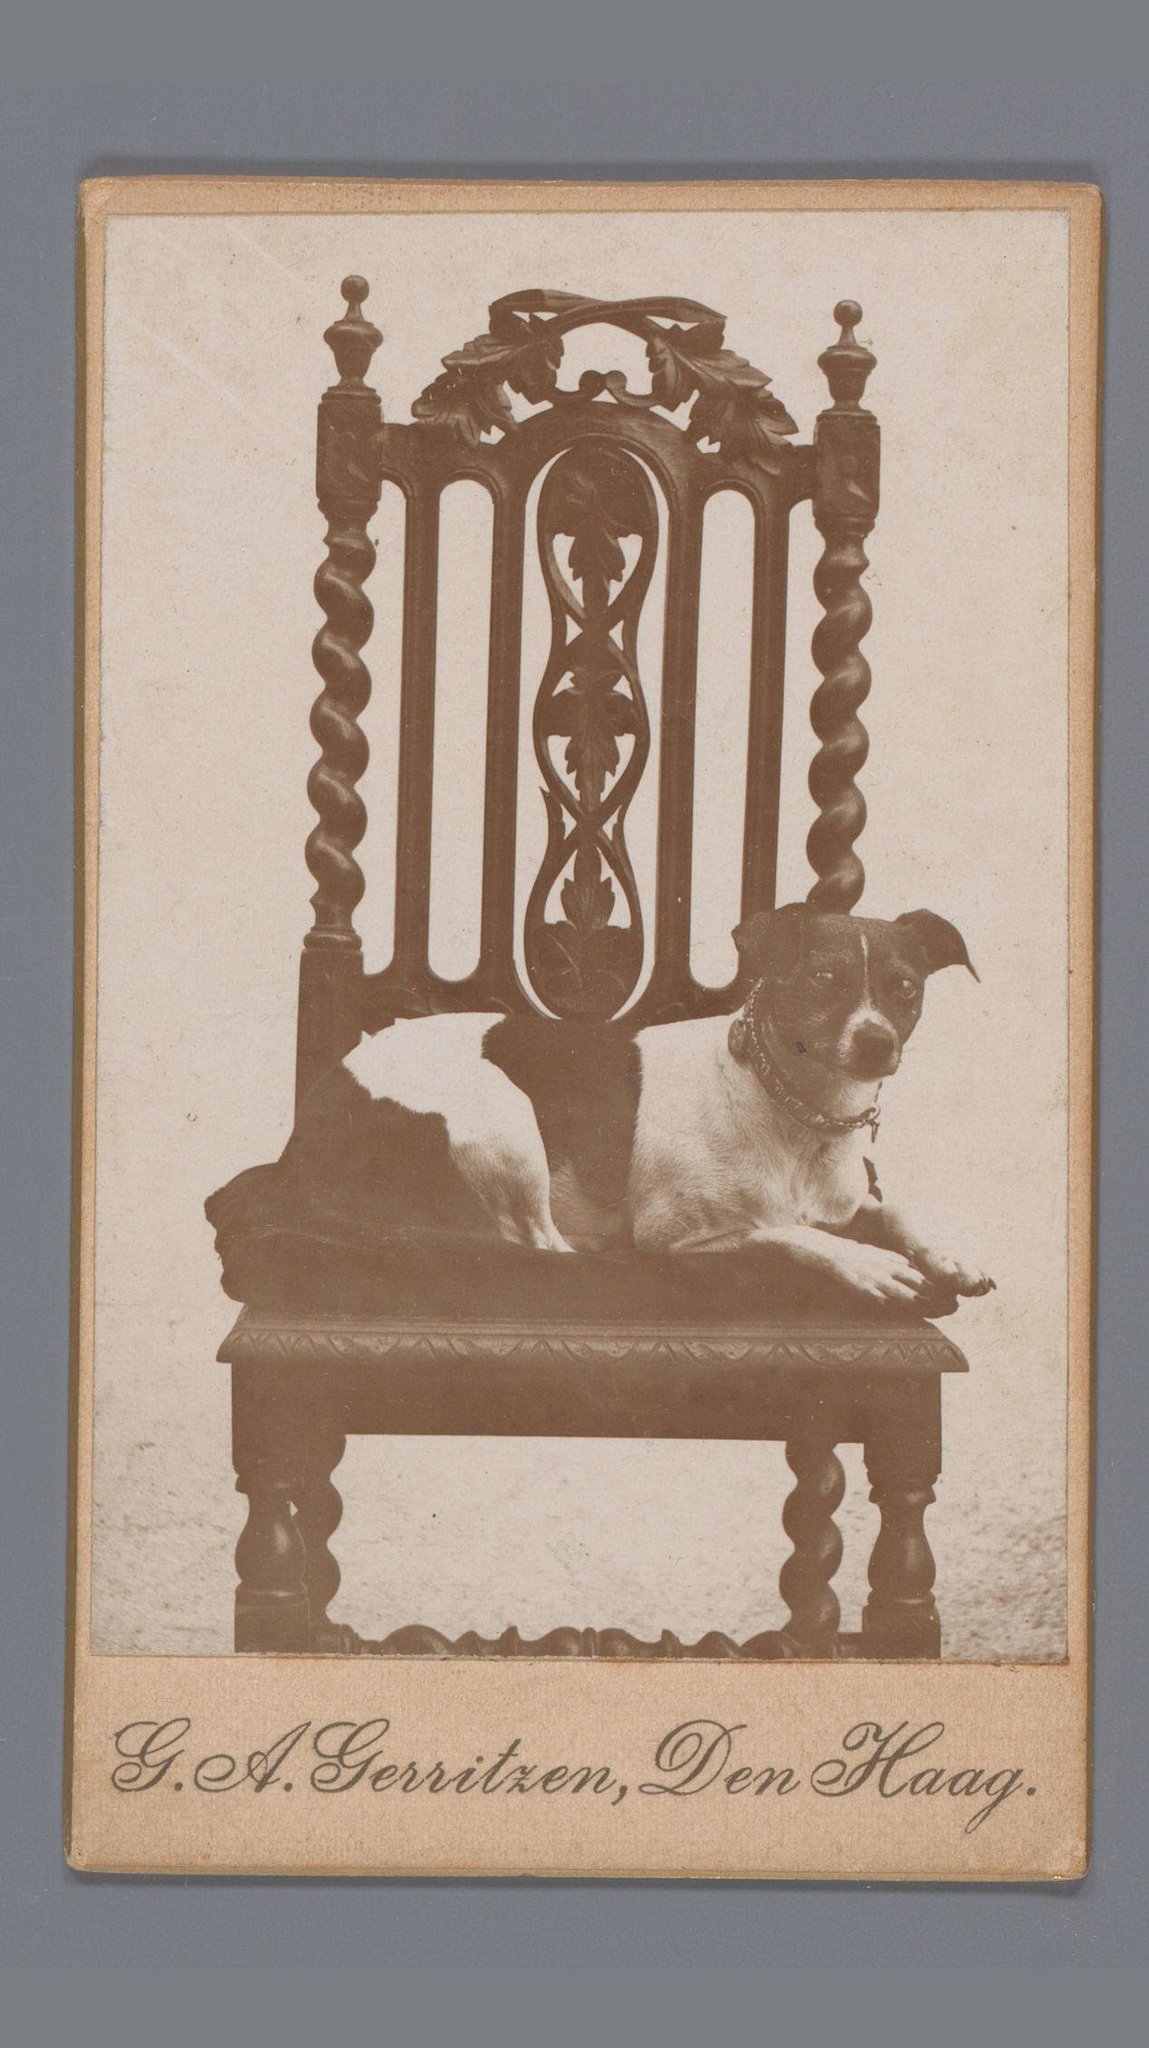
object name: carte de visite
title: Portret van een hond op een stoel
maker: g. a. gerritzen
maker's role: fotograaf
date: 1880-1914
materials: paper, cardboard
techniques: collodion silver print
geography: the hague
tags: anonymous historical person portrayed, dog